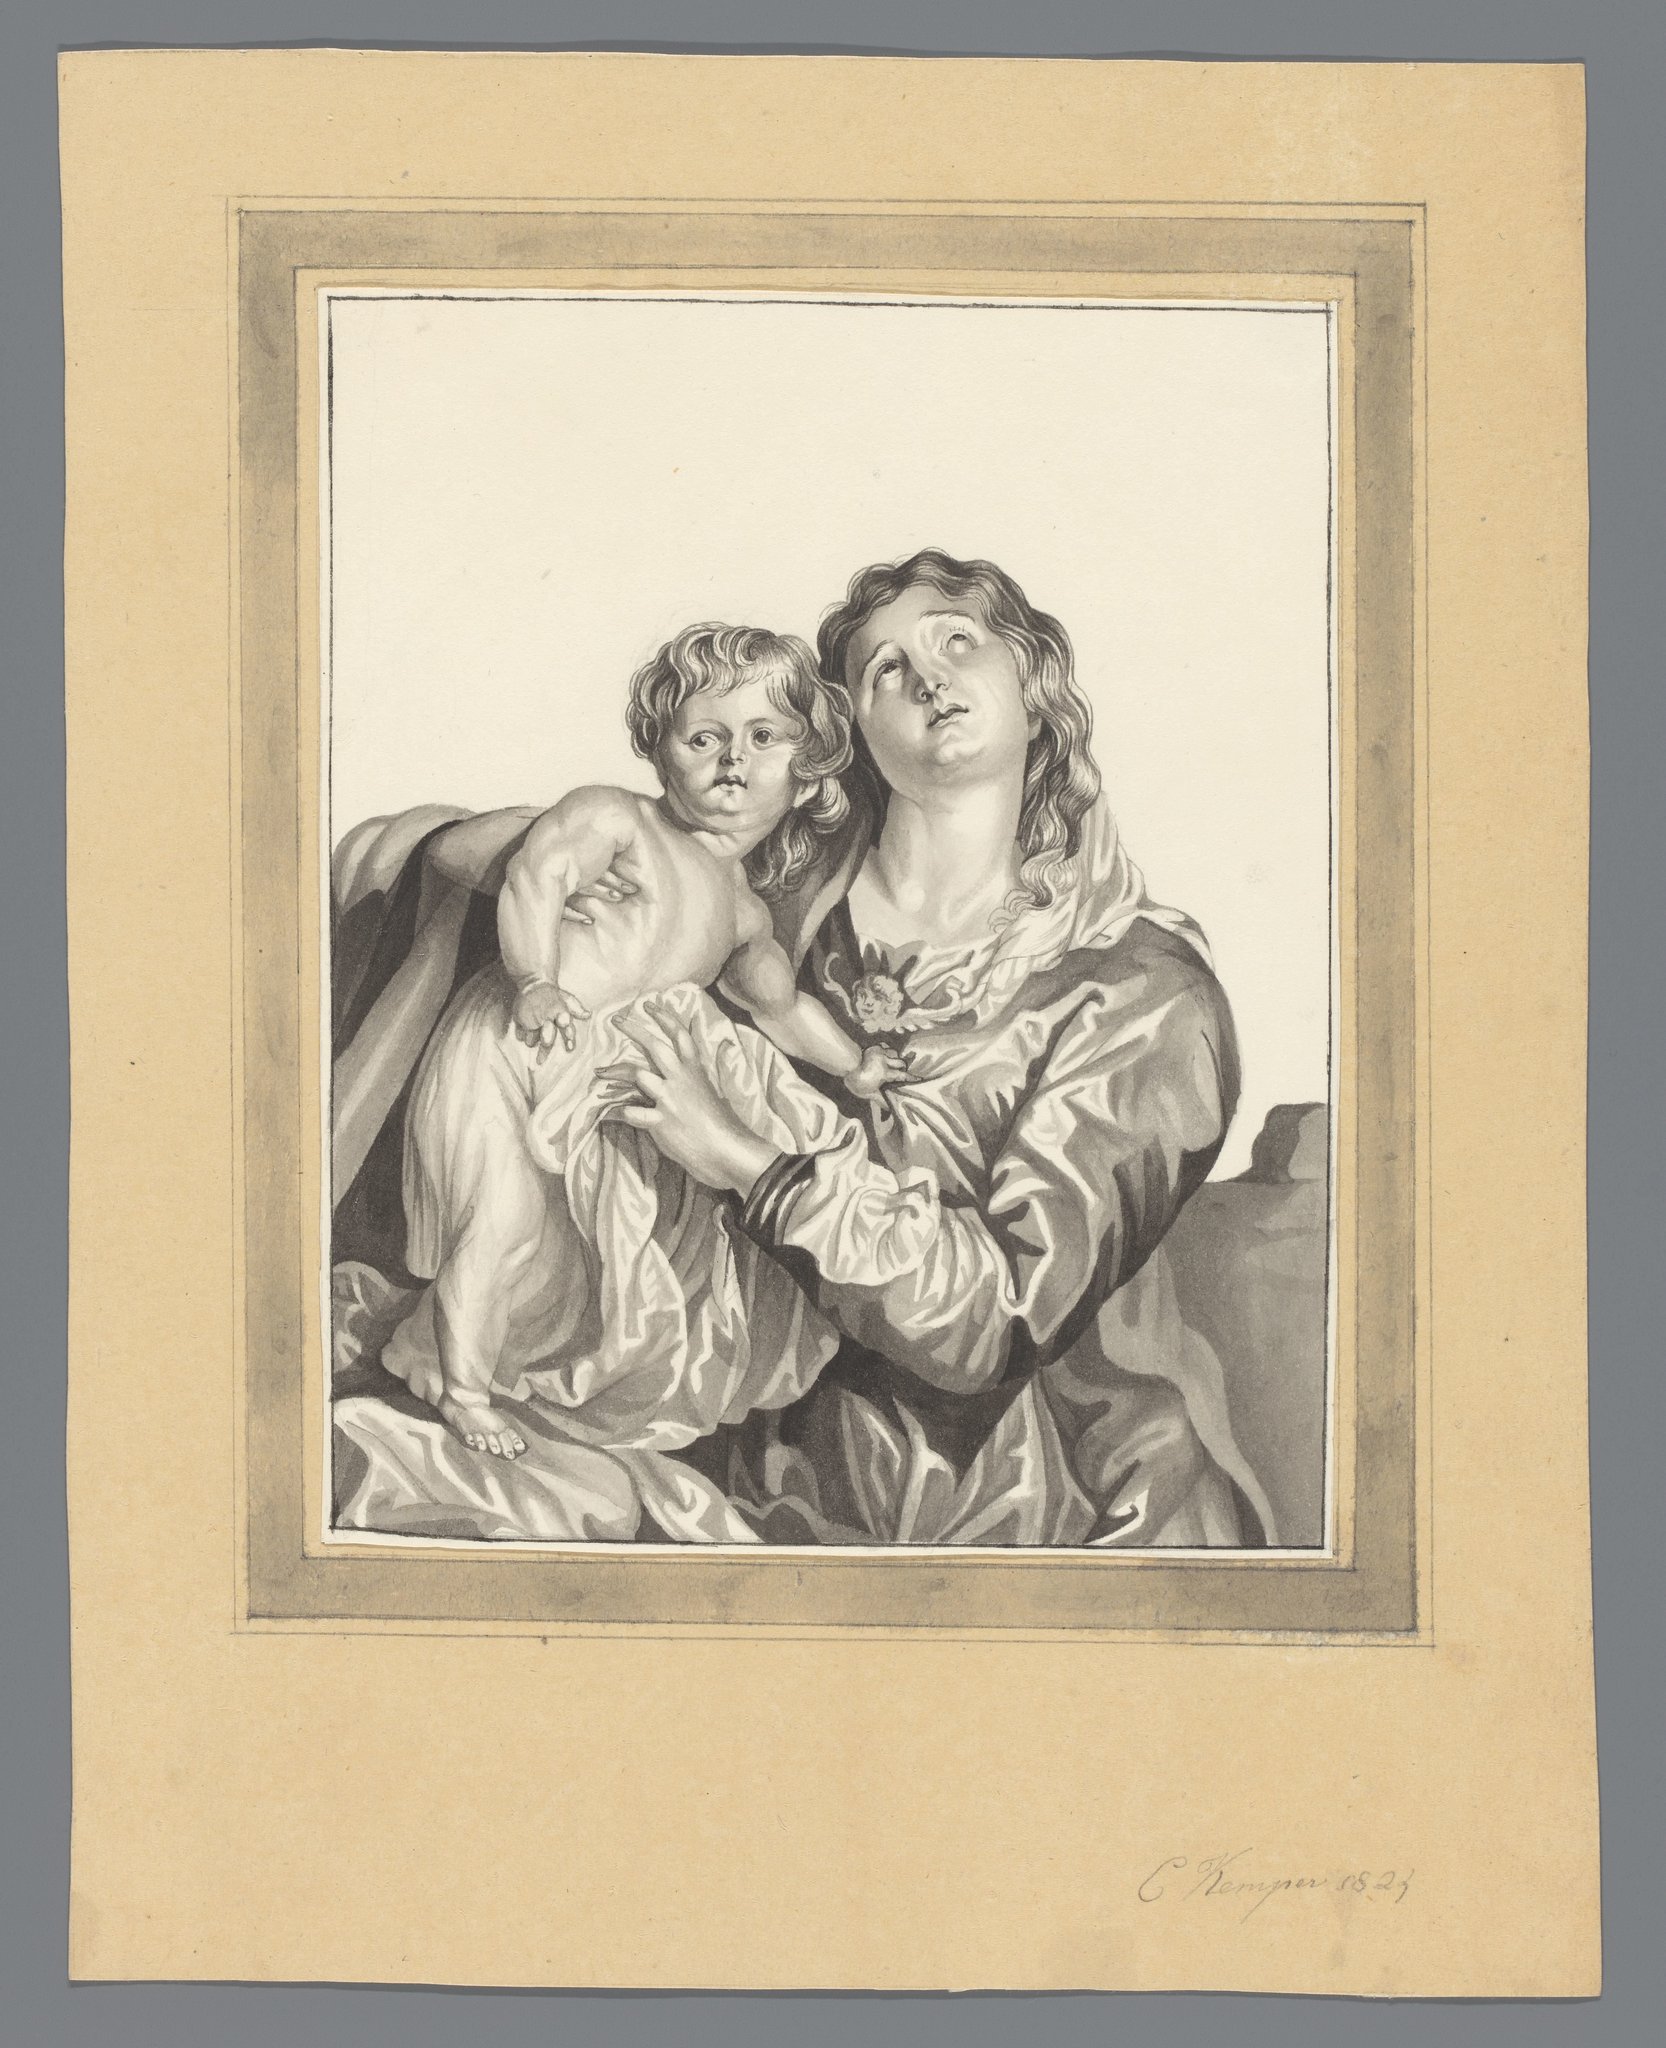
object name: drawing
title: Maria met kind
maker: jonkvrouw catharina kemper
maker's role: draughtsman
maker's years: 1801-1871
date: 1824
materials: ink, paper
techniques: brush, pen